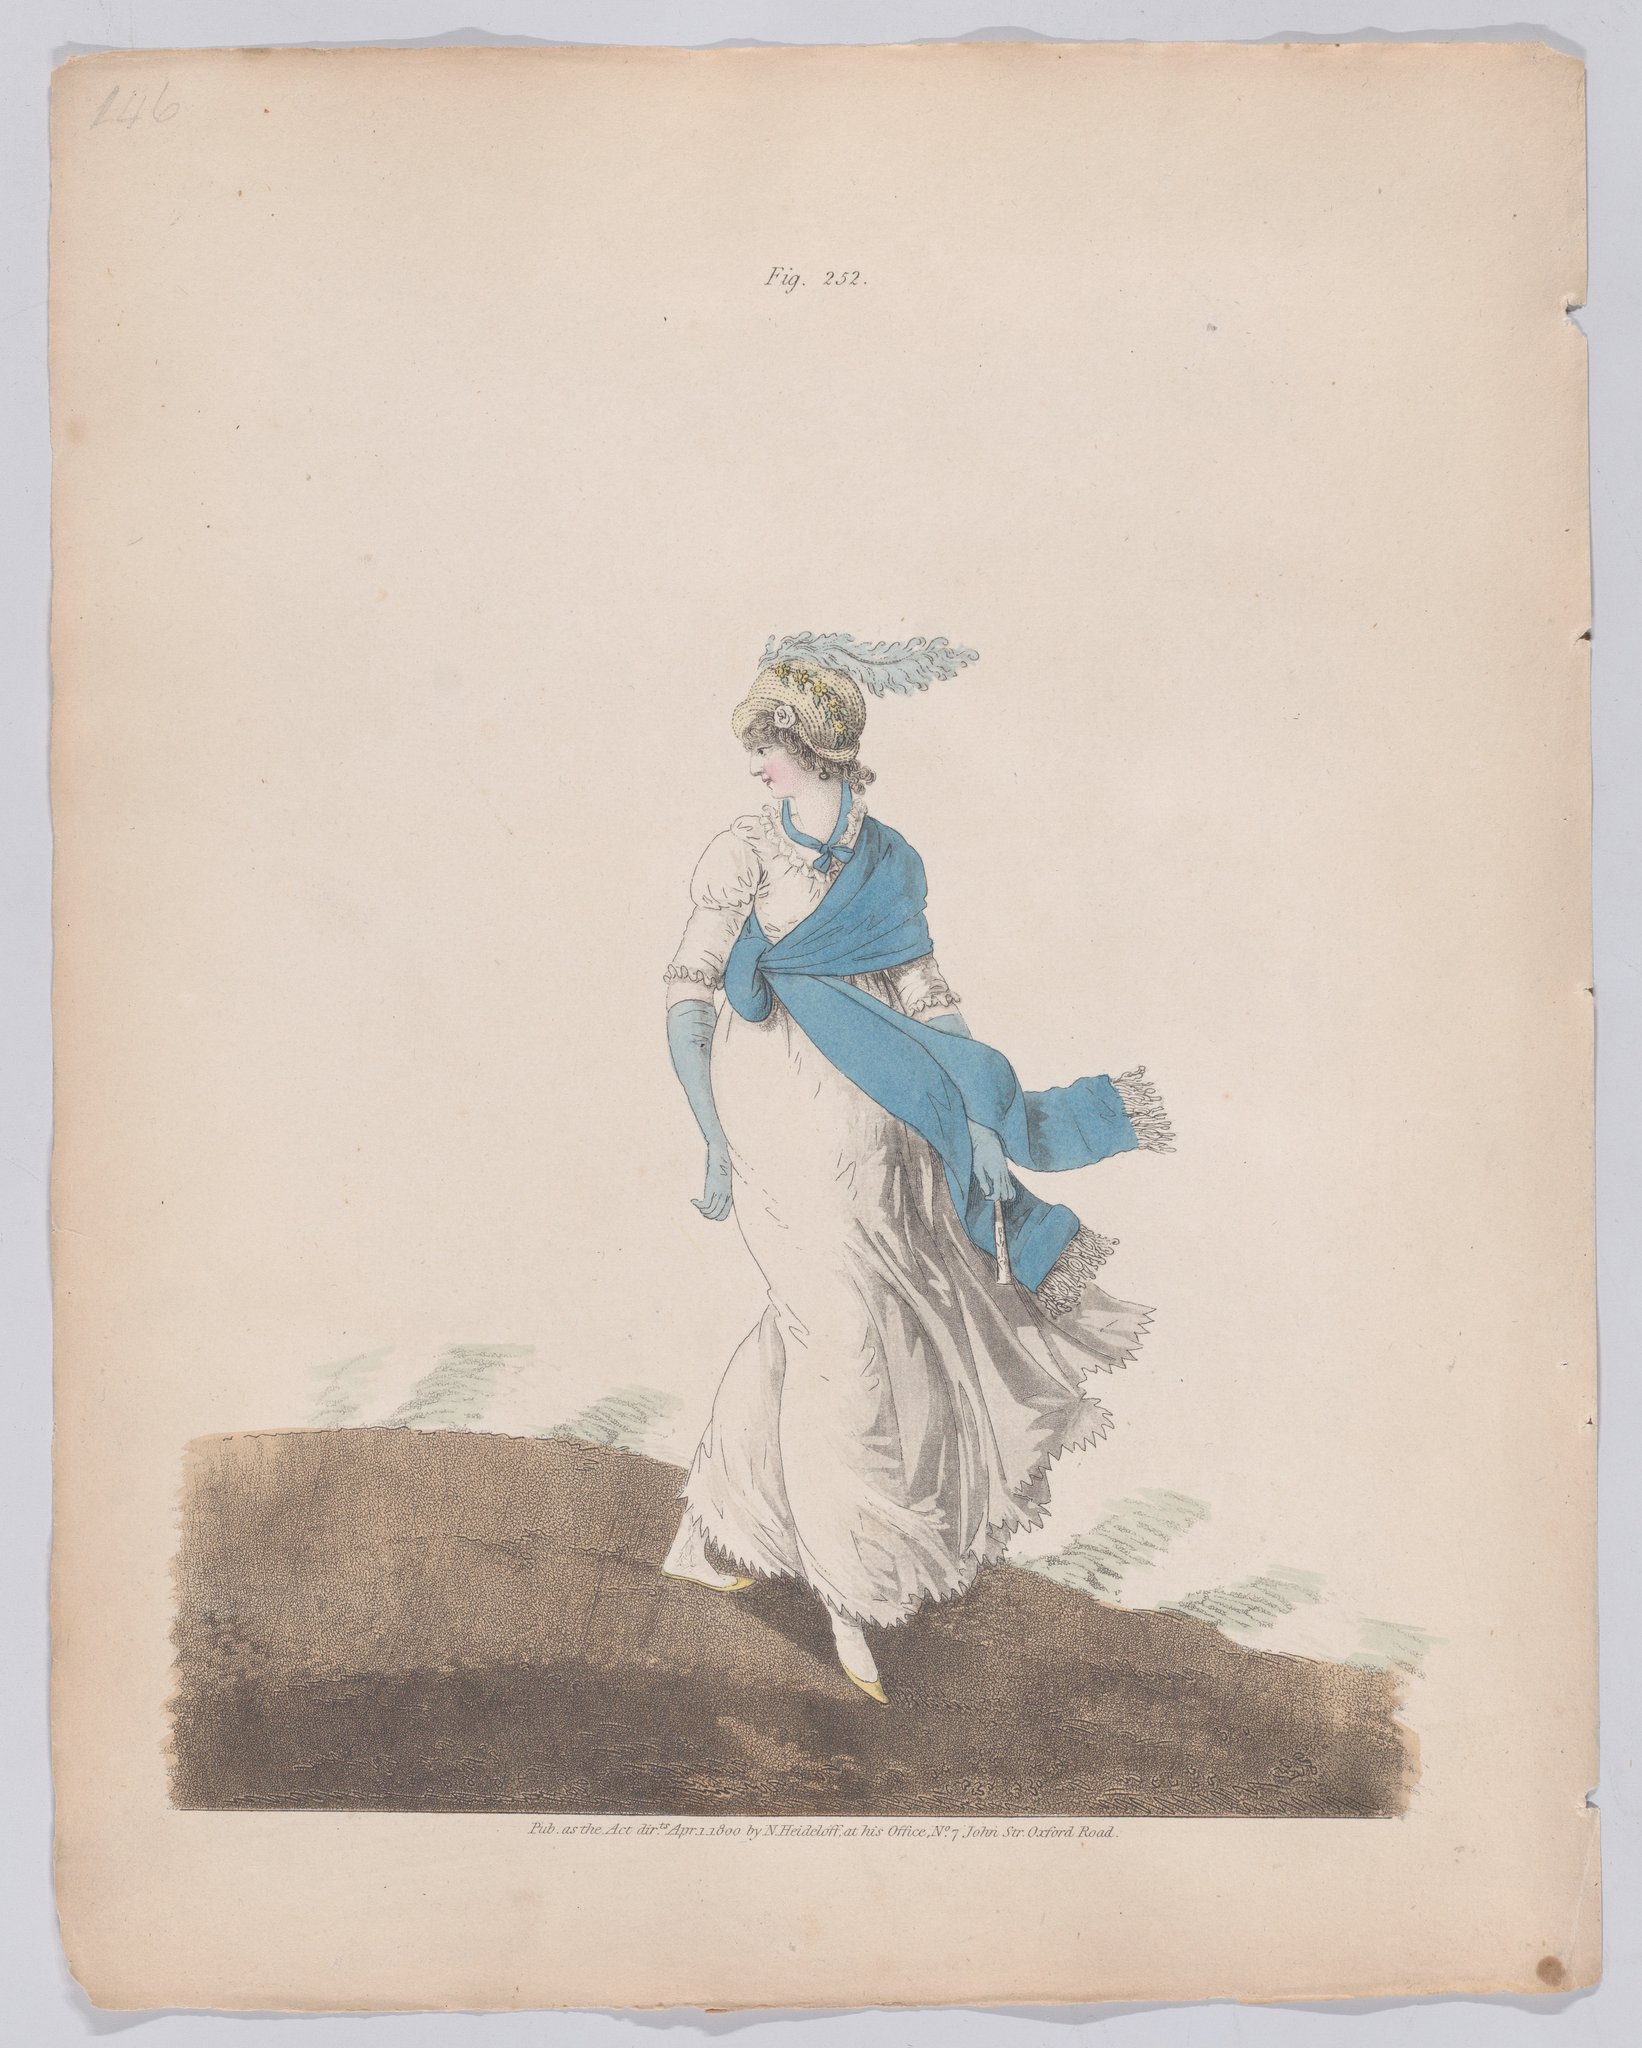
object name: book costume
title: Gallery of Fashion, vol. VII: April 1 1800 - March 1 1801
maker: nicolaus heideloff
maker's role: publisher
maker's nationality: british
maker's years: 1761-1837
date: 1794-1802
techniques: engraving, etching, hand coloring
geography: england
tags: women,fashion